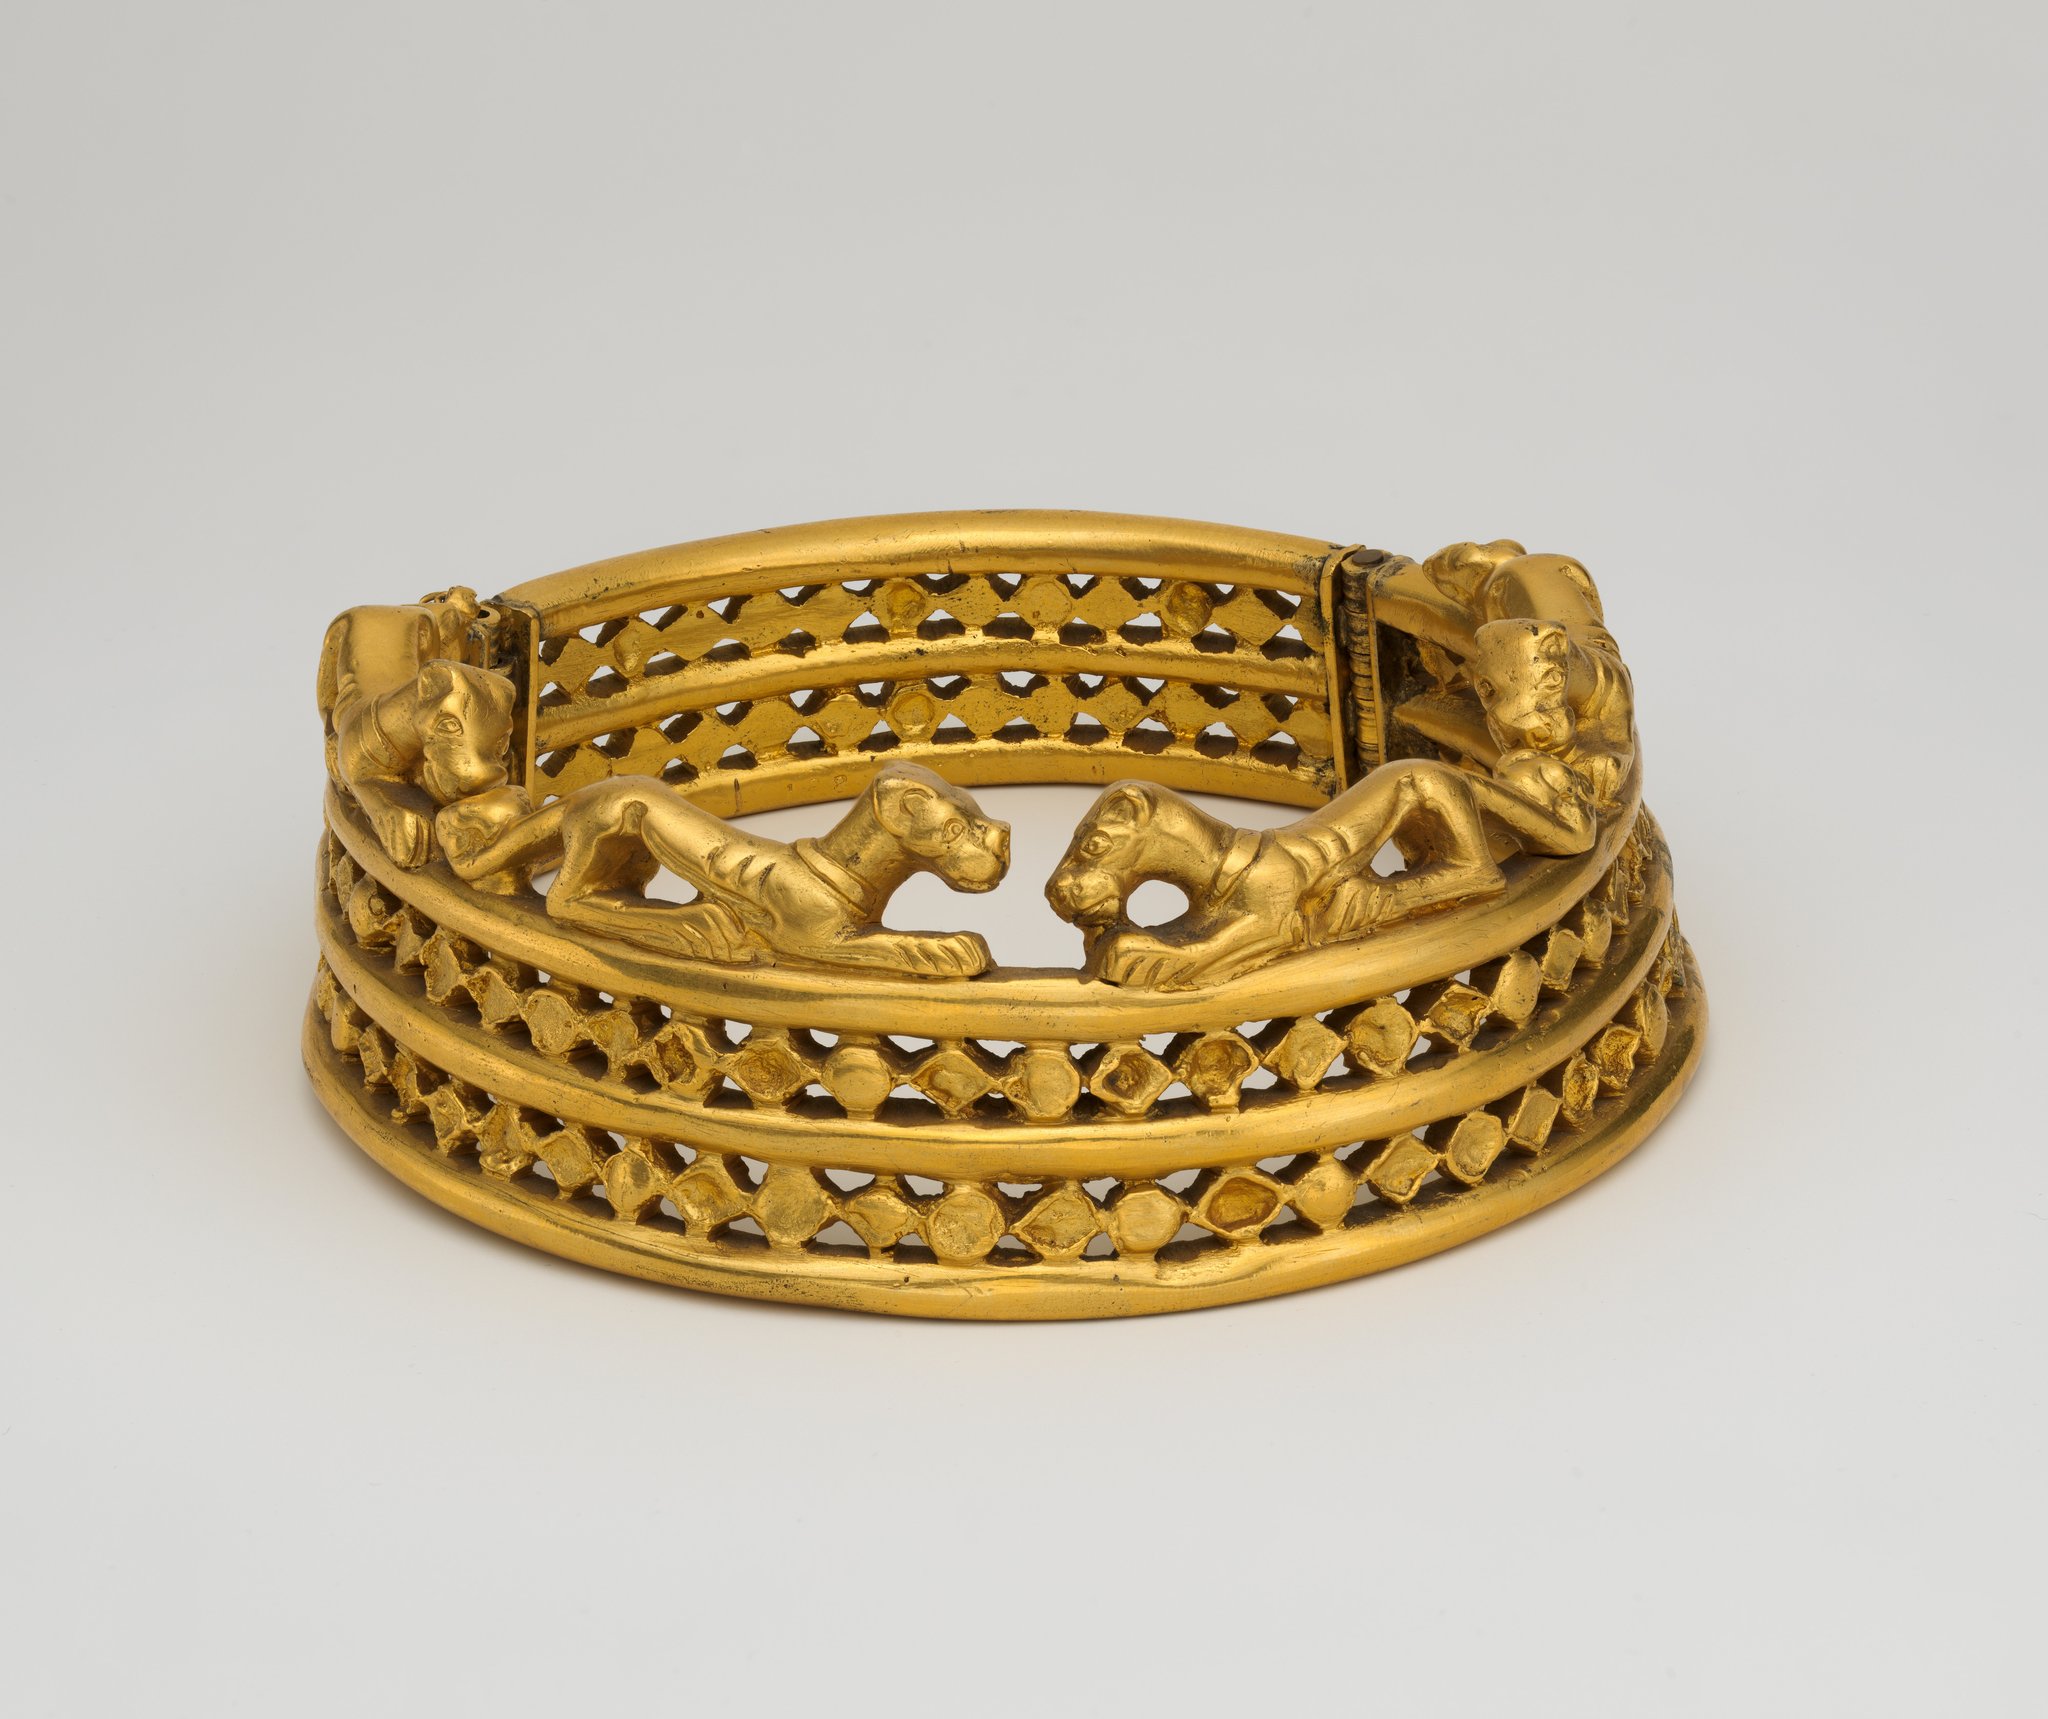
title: Reproduction of a Sarmatian collar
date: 1801-1900